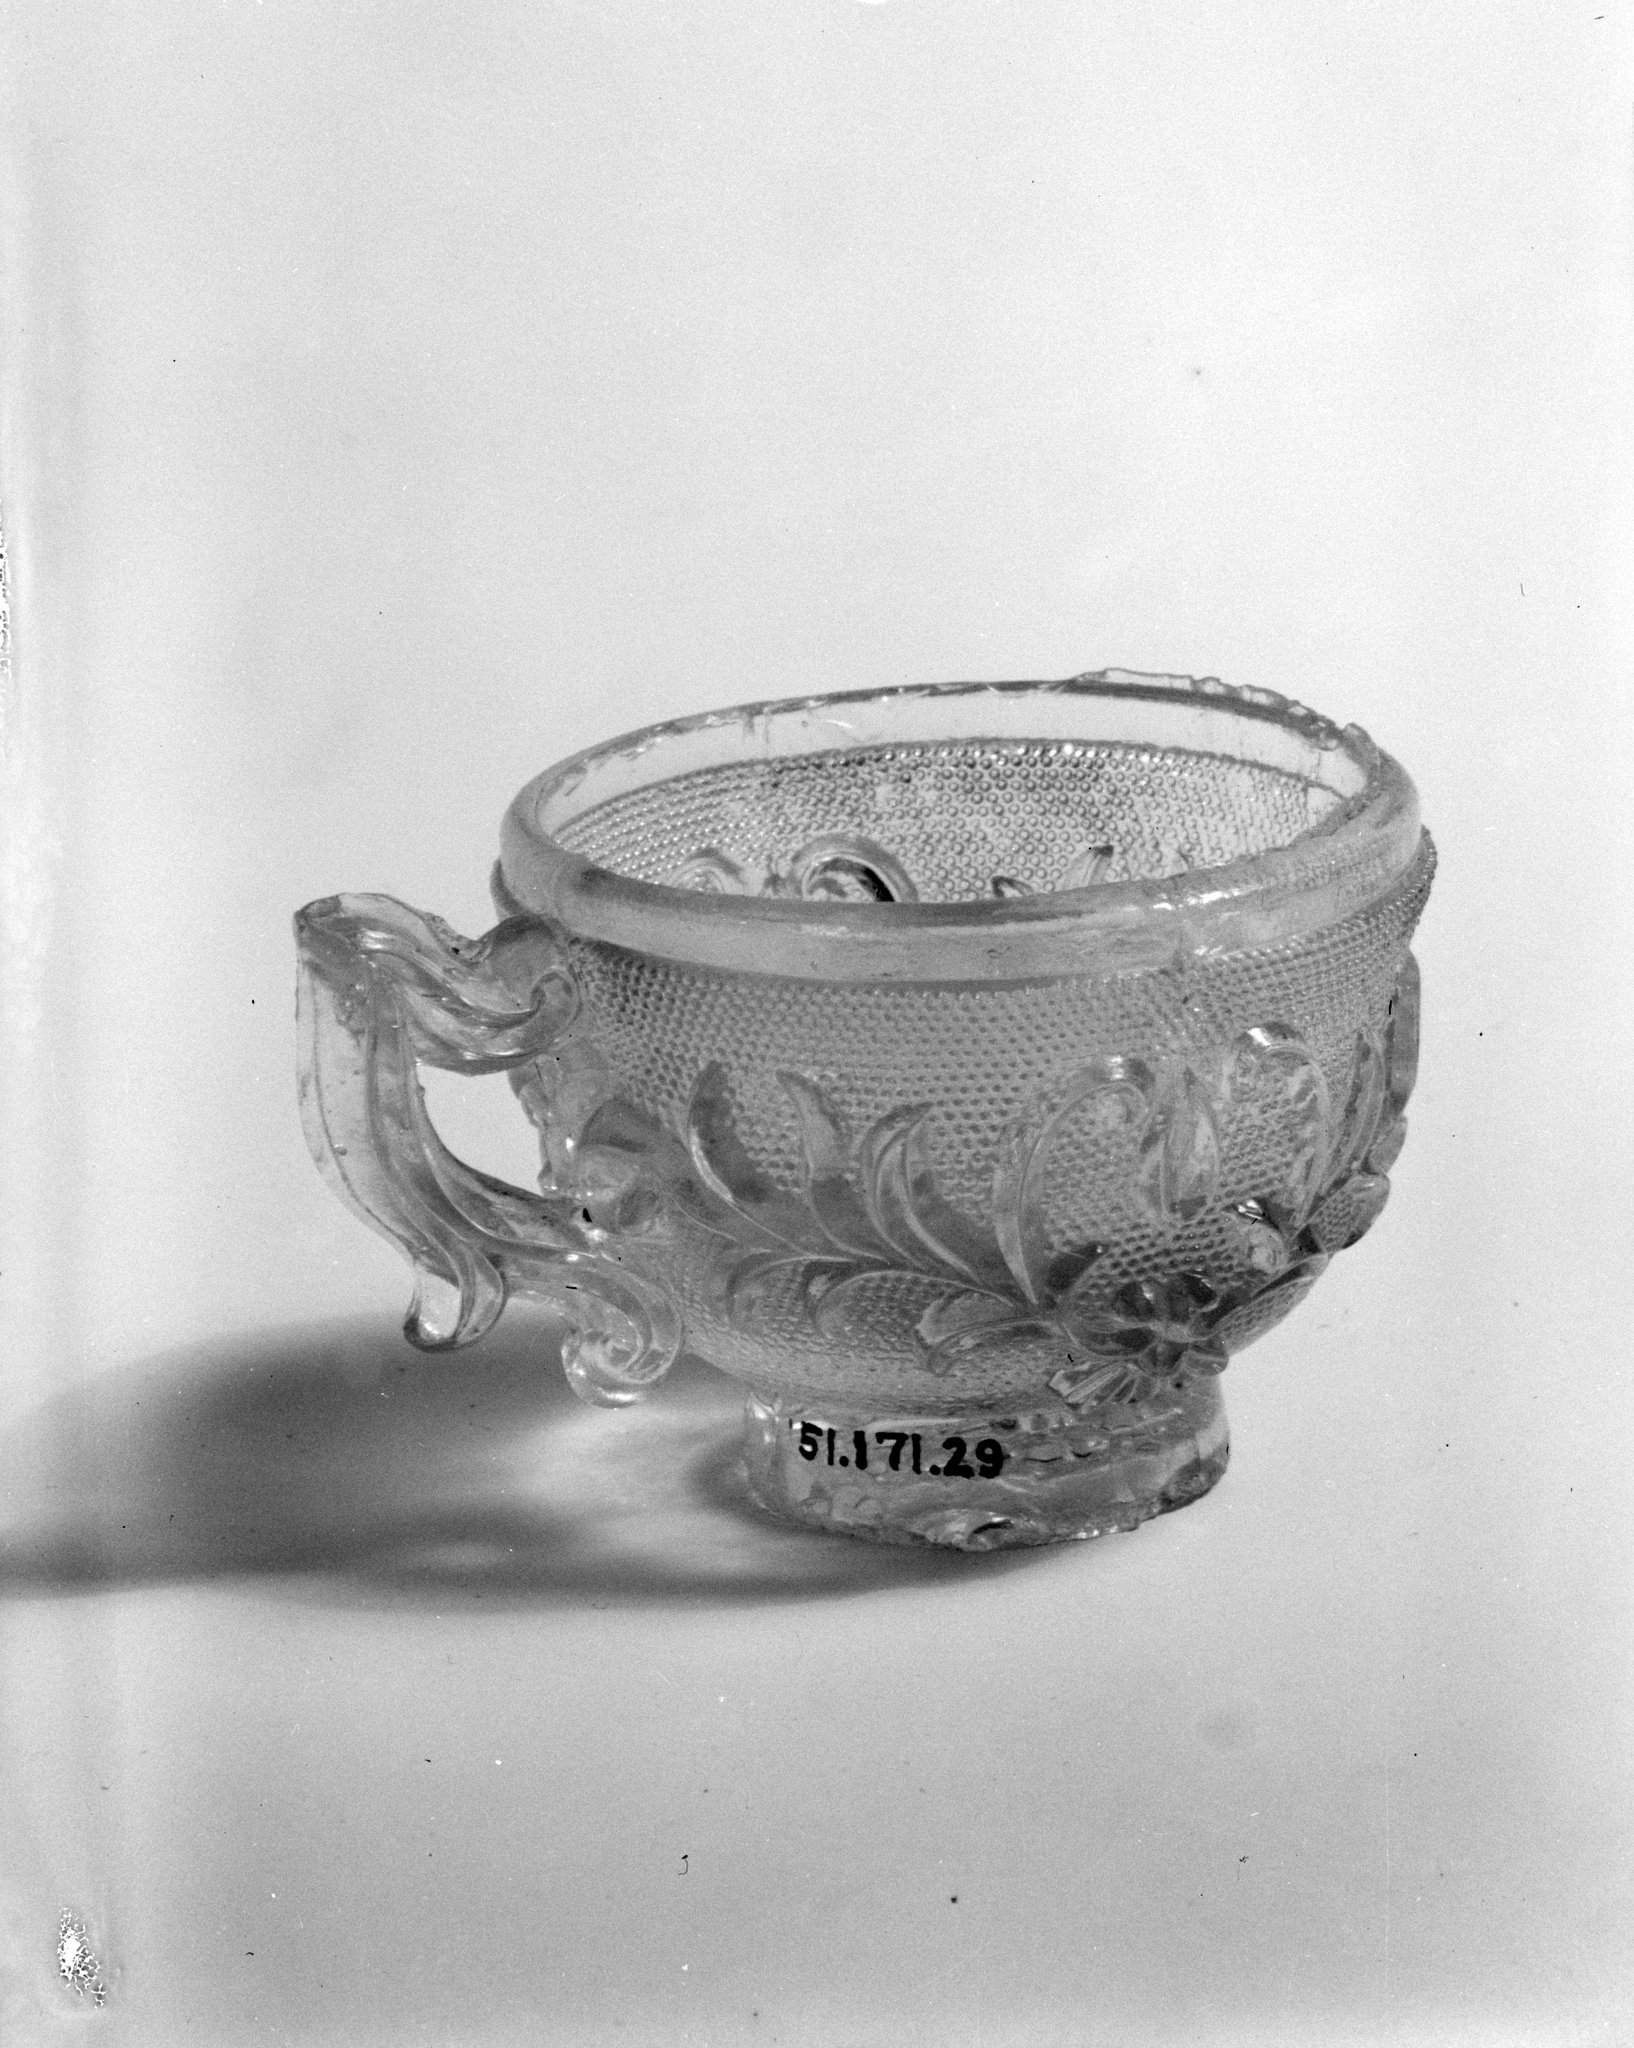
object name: cup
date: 1800-1900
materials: glass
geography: france